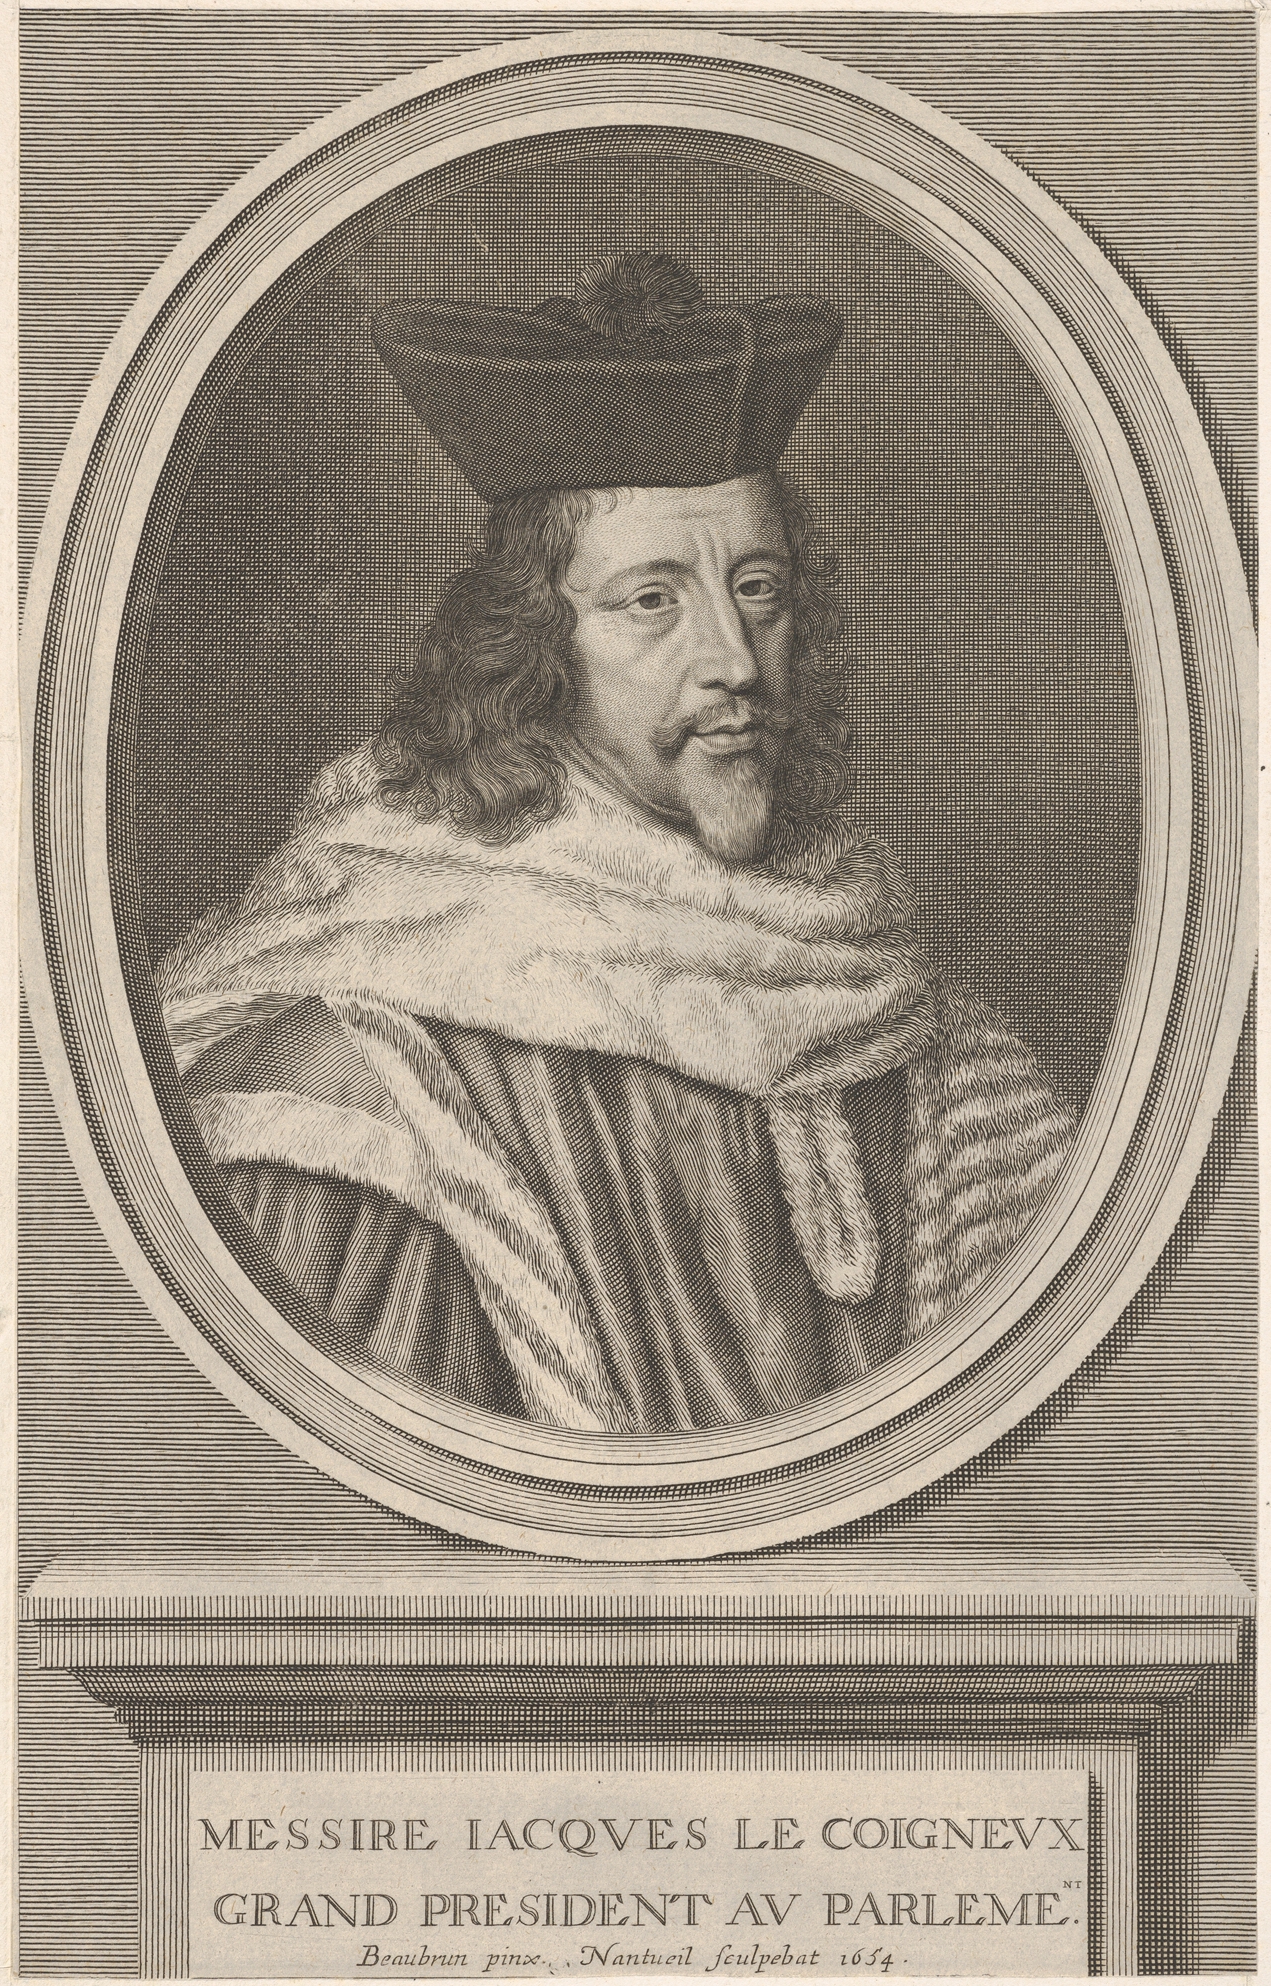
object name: print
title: Jacques Le Coigneux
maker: robert nanteuil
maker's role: artist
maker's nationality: french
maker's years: 1623-1678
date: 1654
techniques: engraving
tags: men,portraits